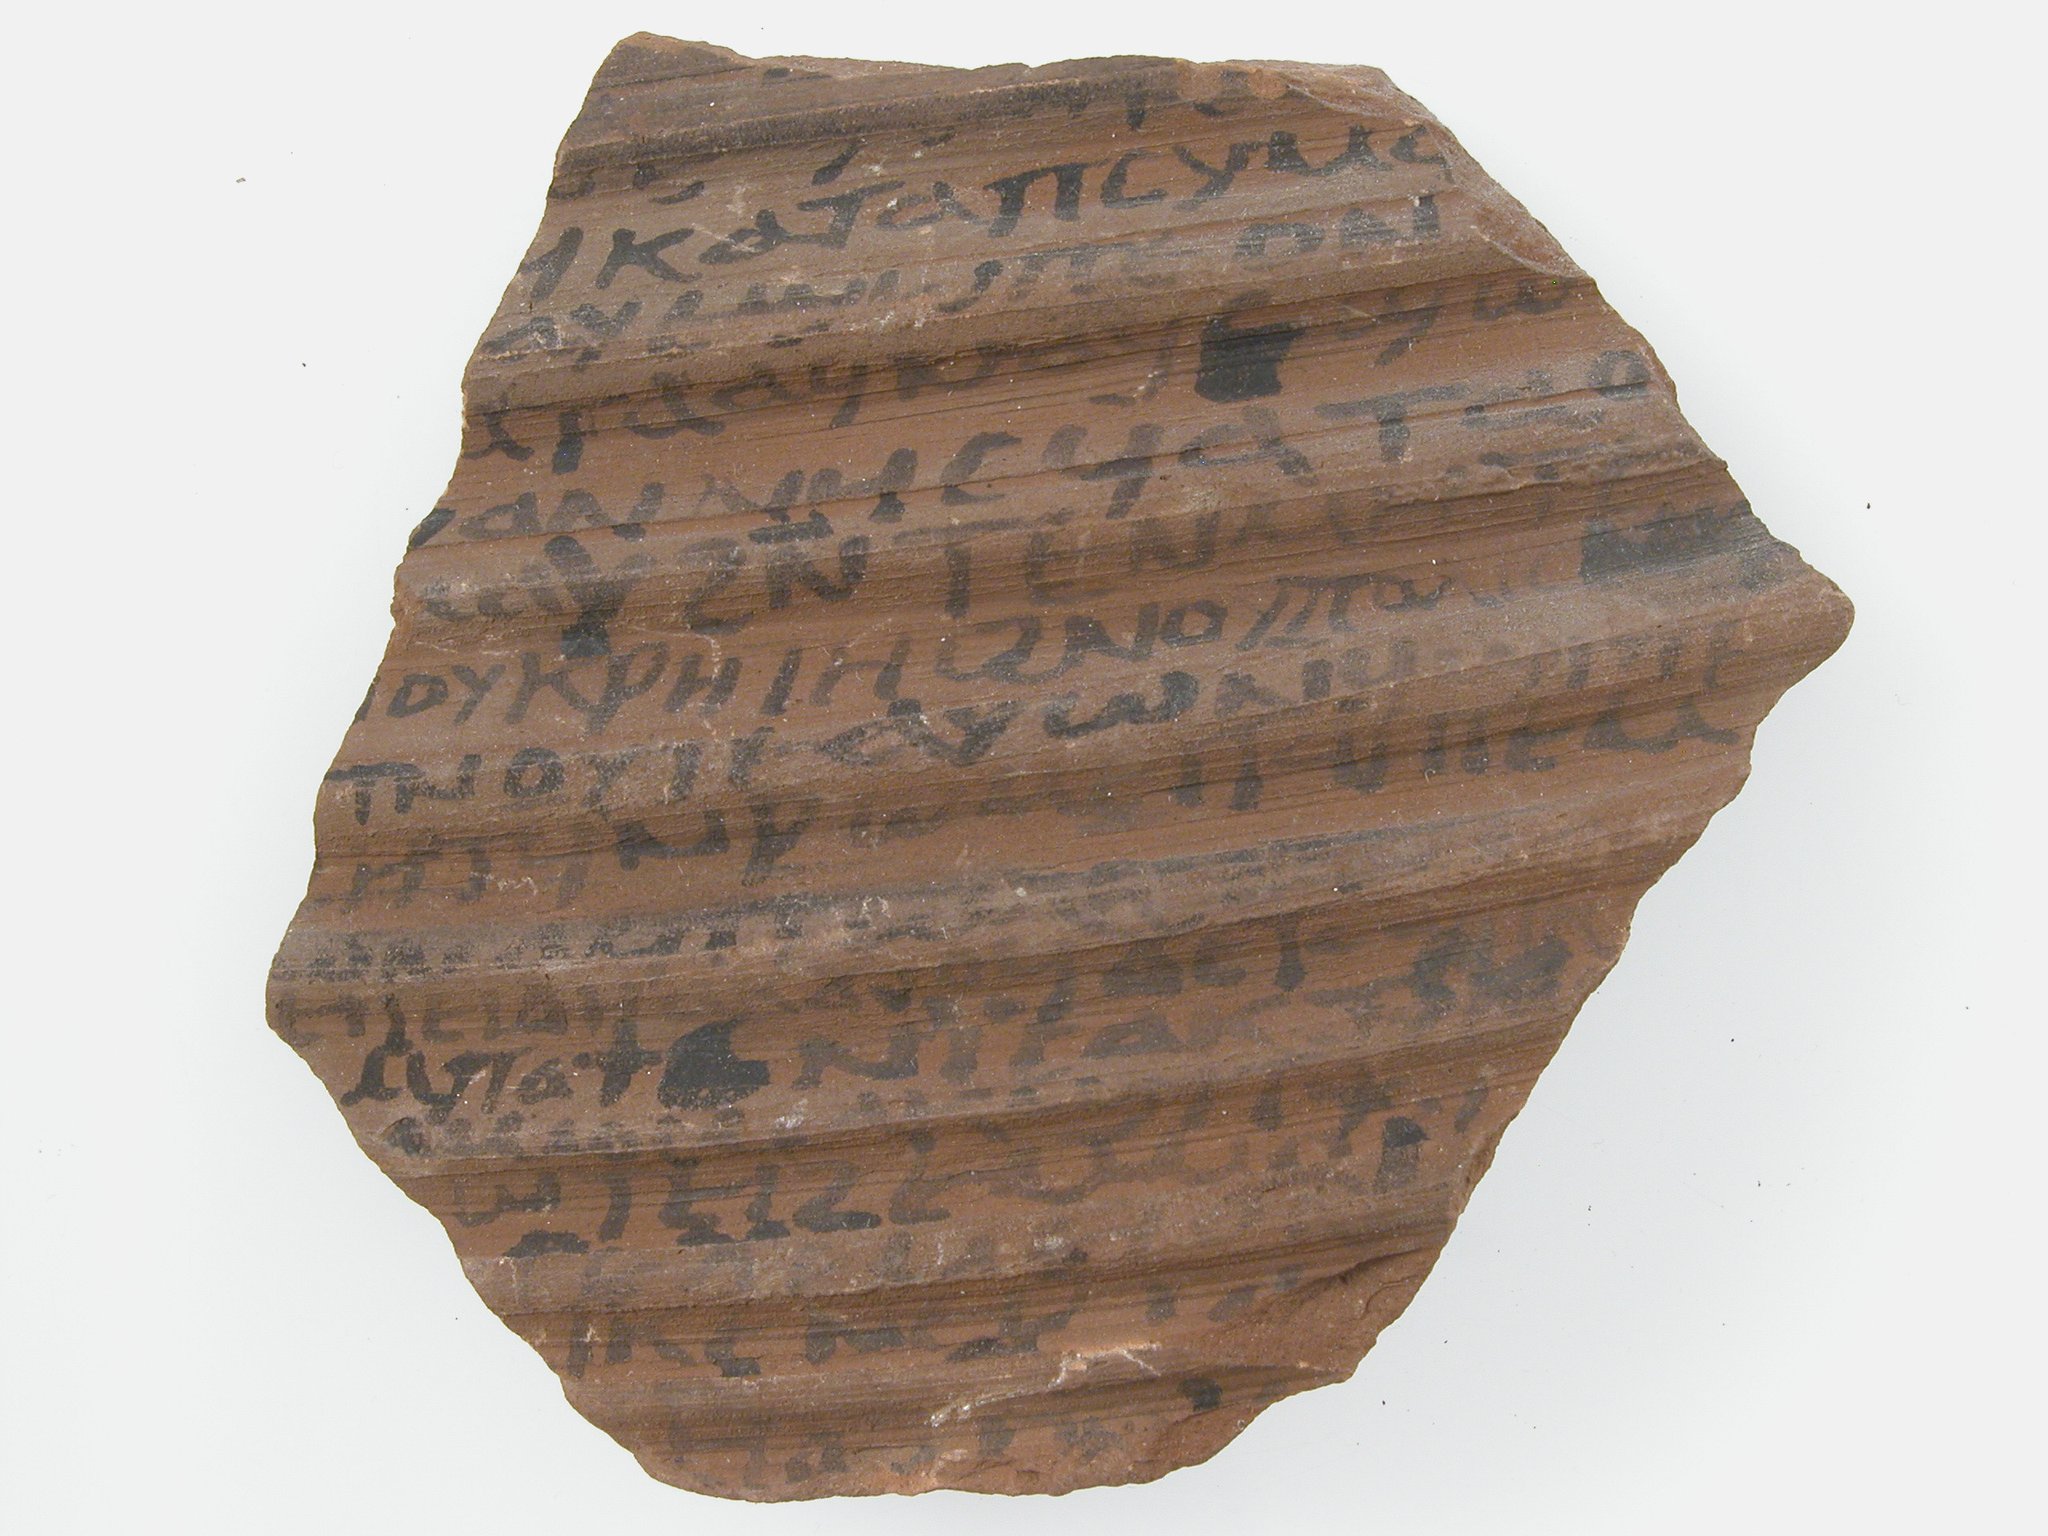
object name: ostrakon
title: Ostrakon with a Letter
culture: coptic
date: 600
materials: ink, pottery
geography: egypt